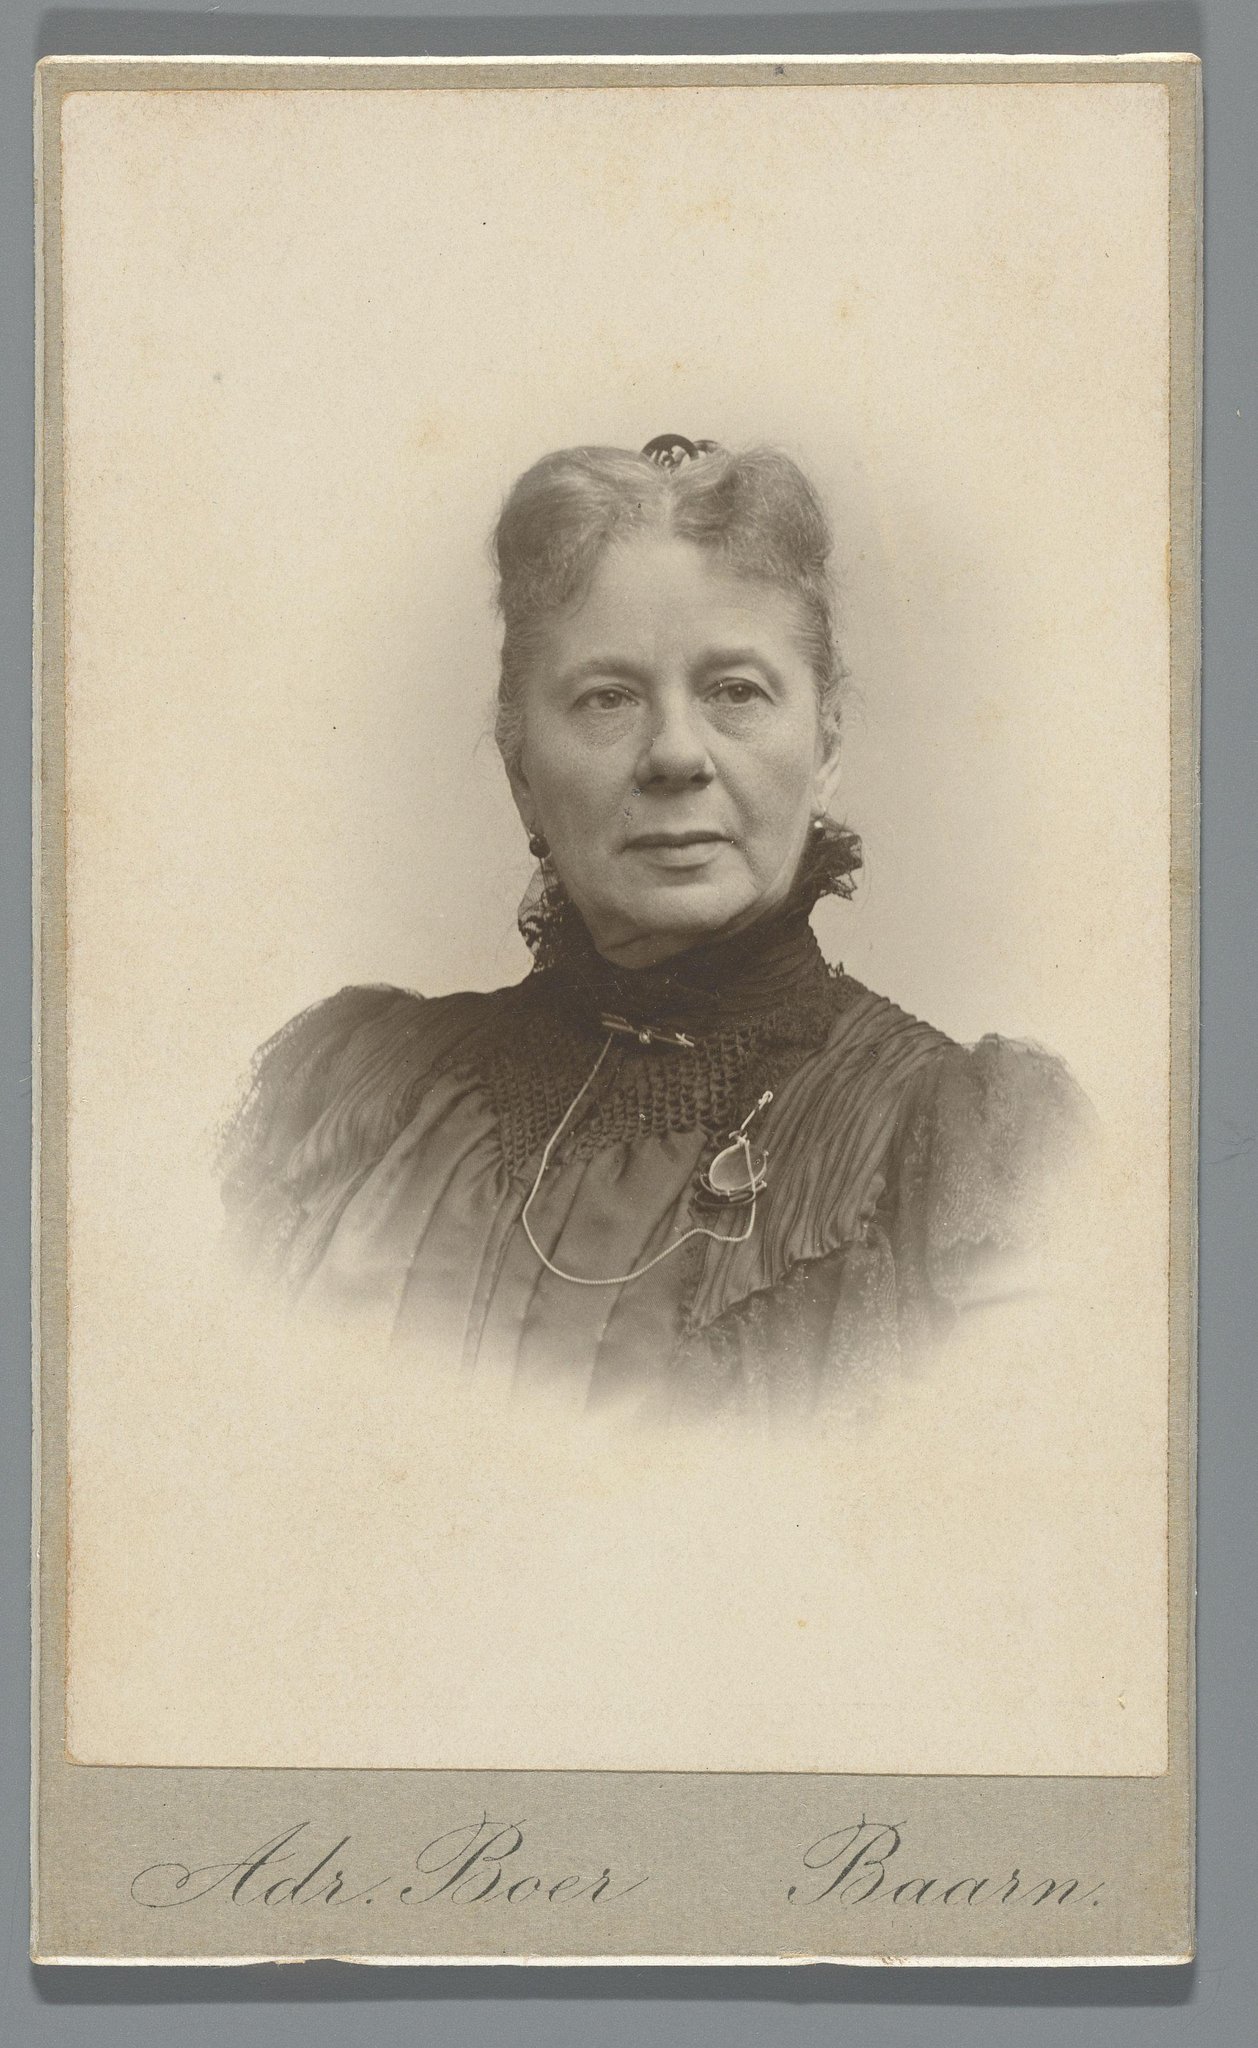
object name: photograph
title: Portret van Pauline Hoogeveen-Holle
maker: adriaan boer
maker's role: fotograaf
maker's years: 1875-1940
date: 1870-1920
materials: cardboard, photographic support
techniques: albumen print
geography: baarn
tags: koblenz, pauline wilhelmine louise hoogeveen-holle (pau)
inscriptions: name: ‘Tante Pau Hoogeveen / Holle.’, name: ‘Adr. Boer Baarn’